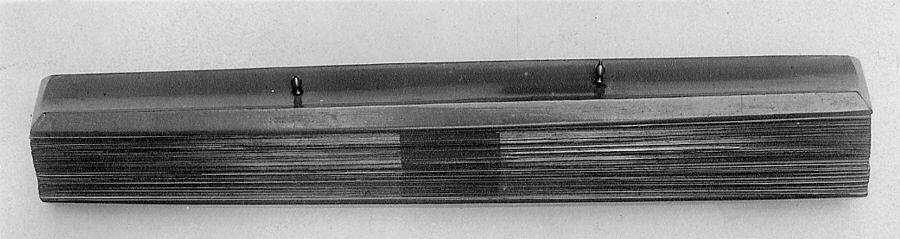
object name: manuscript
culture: burmese